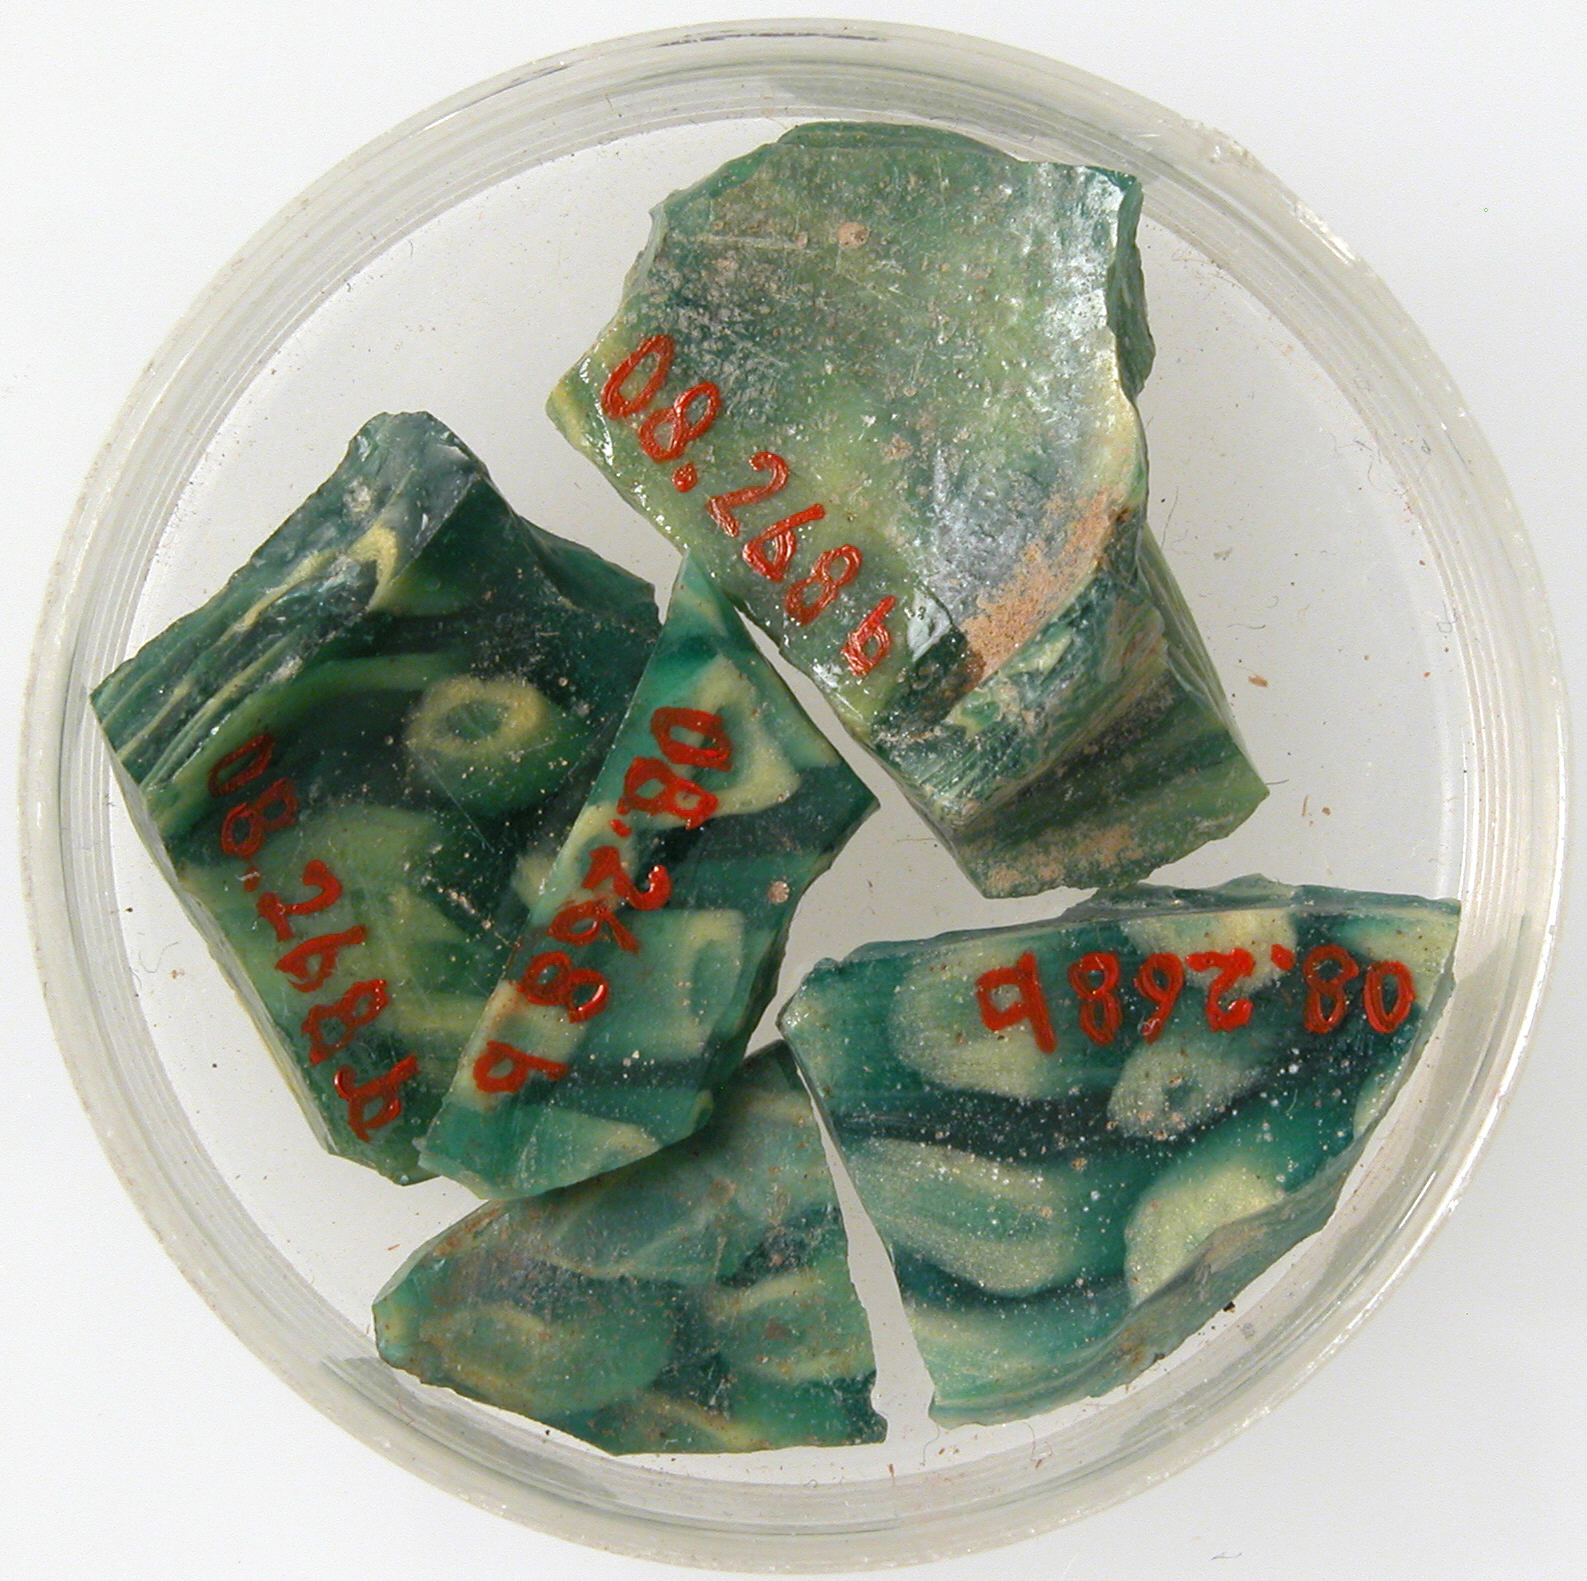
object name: fragment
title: Glass Fragments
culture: coptic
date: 301-433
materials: glass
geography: egypt